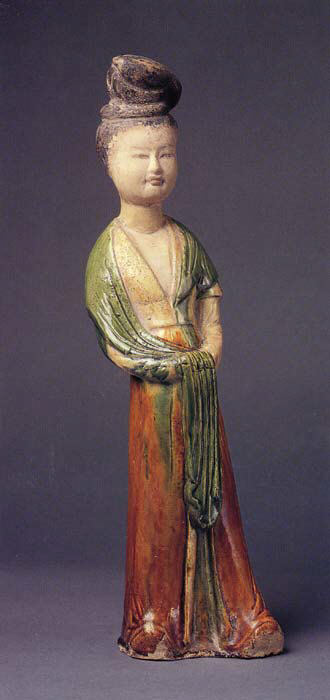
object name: figure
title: Standing court lady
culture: chinese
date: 701-800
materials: earthenware, glaze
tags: women